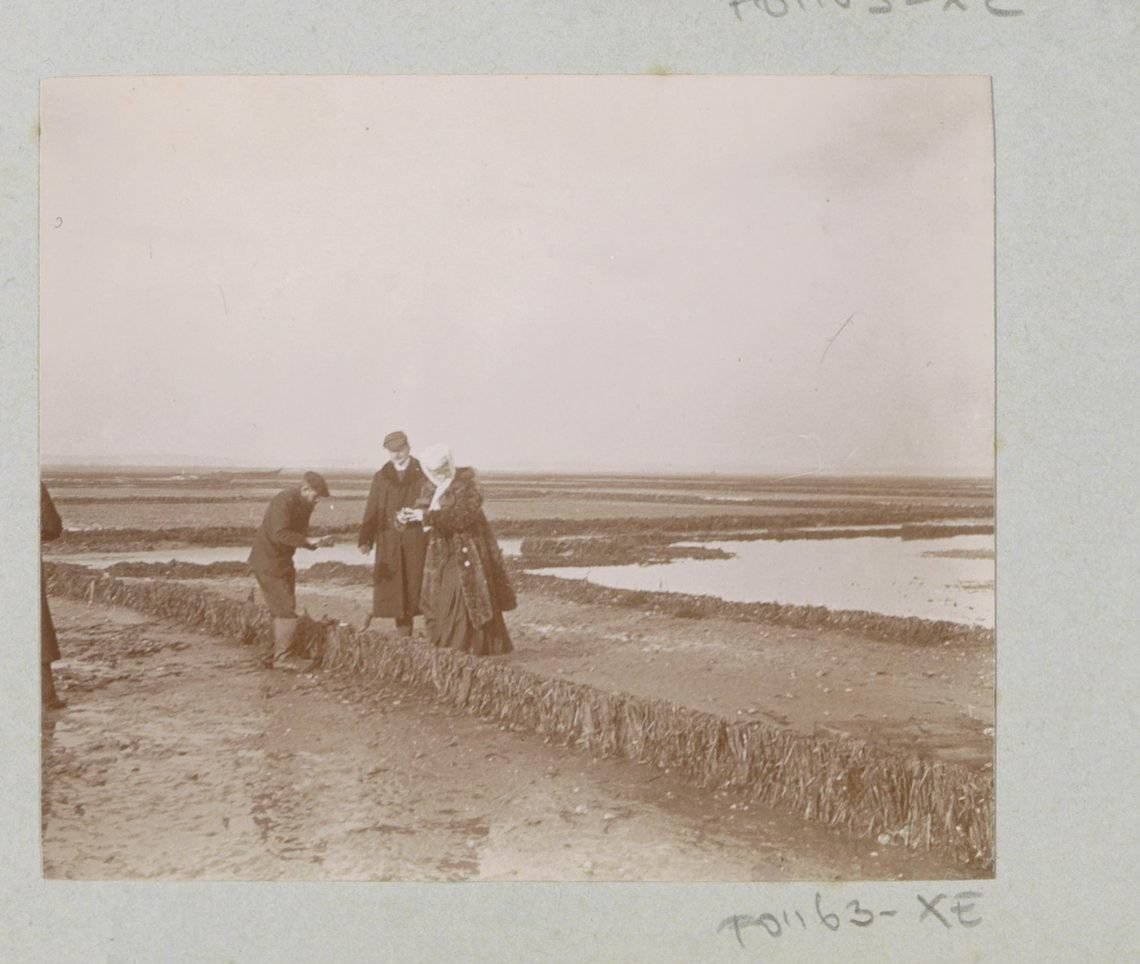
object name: photograph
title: Twee mannen en een vrouw, mogelijk iets proevend op een wad in Frankrijk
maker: delizy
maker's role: manufacturer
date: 1904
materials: paper, photographic support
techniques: gelatin silver print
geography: france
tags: taste, tasting (one of the five senses), mud flat, france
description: Onderdeel van Fotoalbum van een Franse amateurfotograaf met opnames van uitstapjes in Frankrijk, Spanje, België, Luxemburg en Nederland, de eerste automobielen en autoraces.